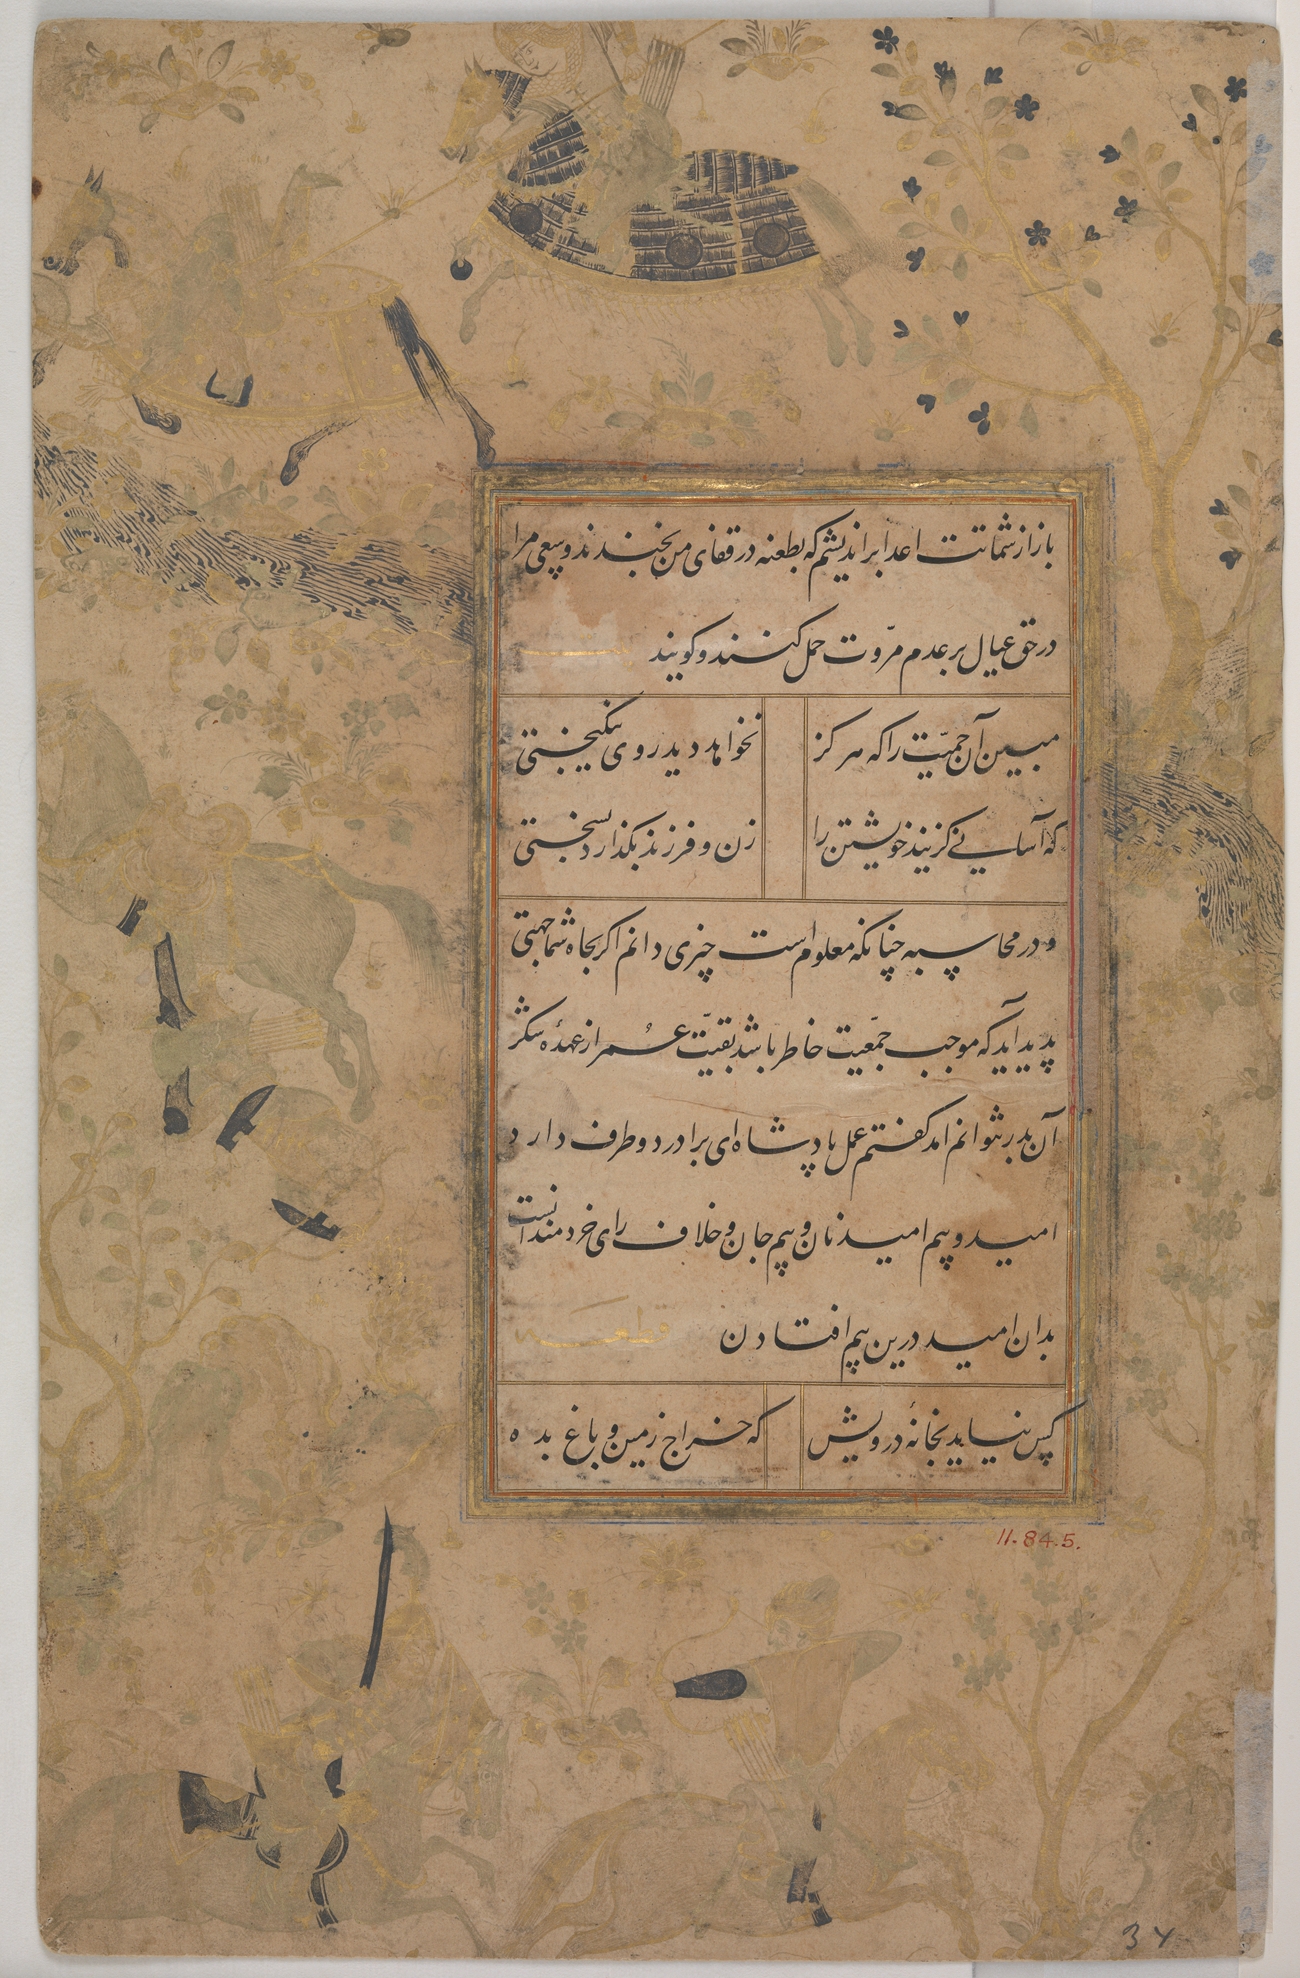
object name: folio from a non illustrated manuscript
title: Page of Calligraphy from an Anthology of Poetry by Sa`di and Hafiz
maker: sa'di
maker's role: author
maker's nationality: iranian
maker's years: 1213-1291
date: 1467-1500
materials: gold, ink, paper, silver, watercolor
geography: afghanistan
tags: poetry,men,horses,calligraphy